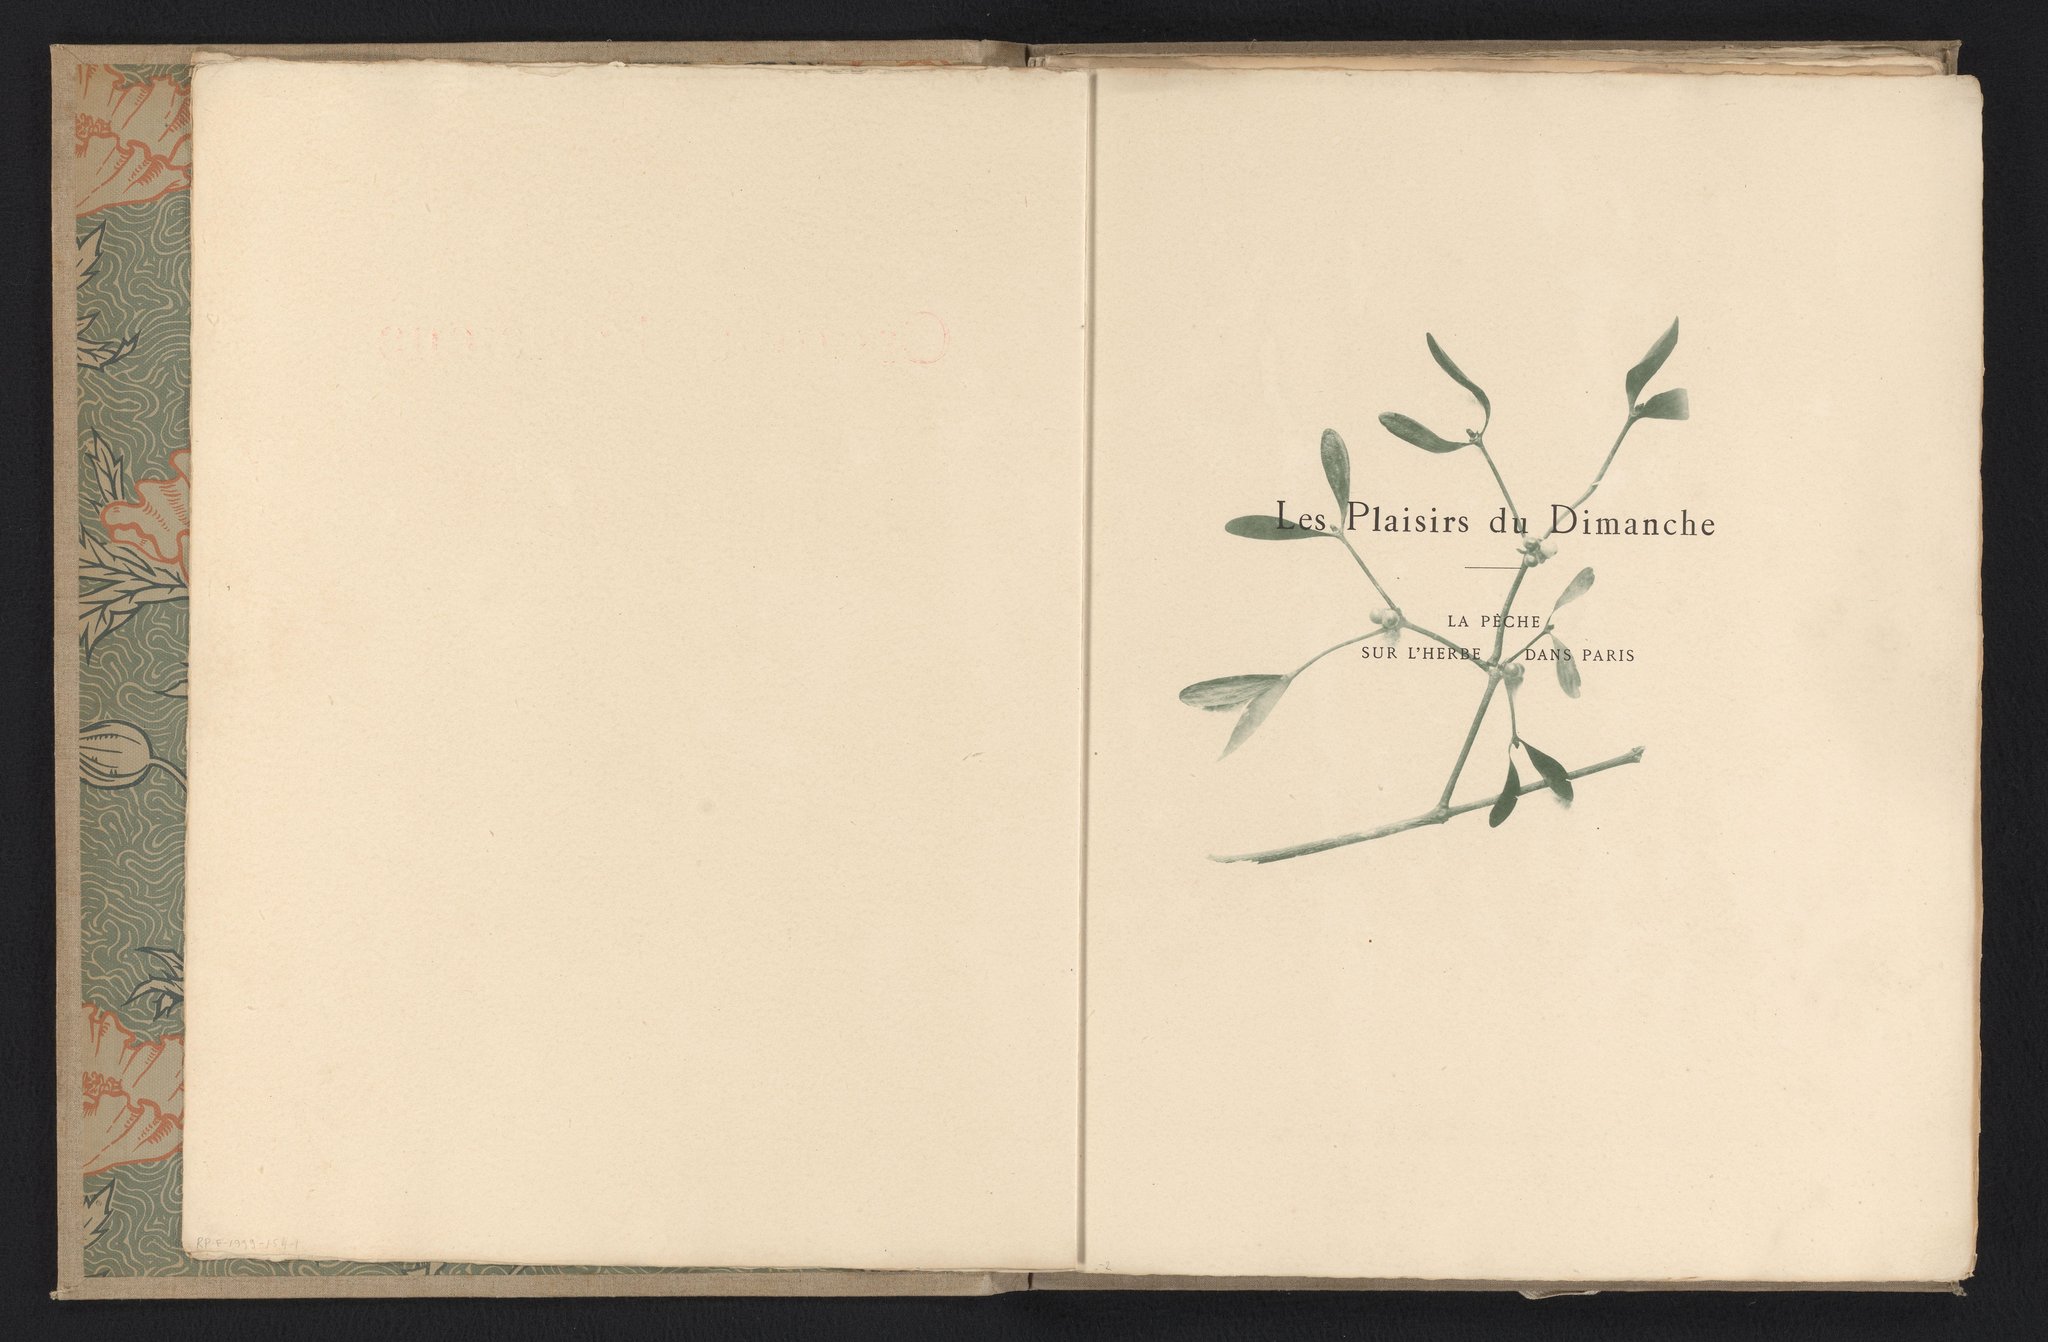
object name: photomechanical print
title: Les plaisirs du dimanche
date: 1896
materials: paper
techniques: photograph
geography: paris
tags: plants and herbs: mistletoe